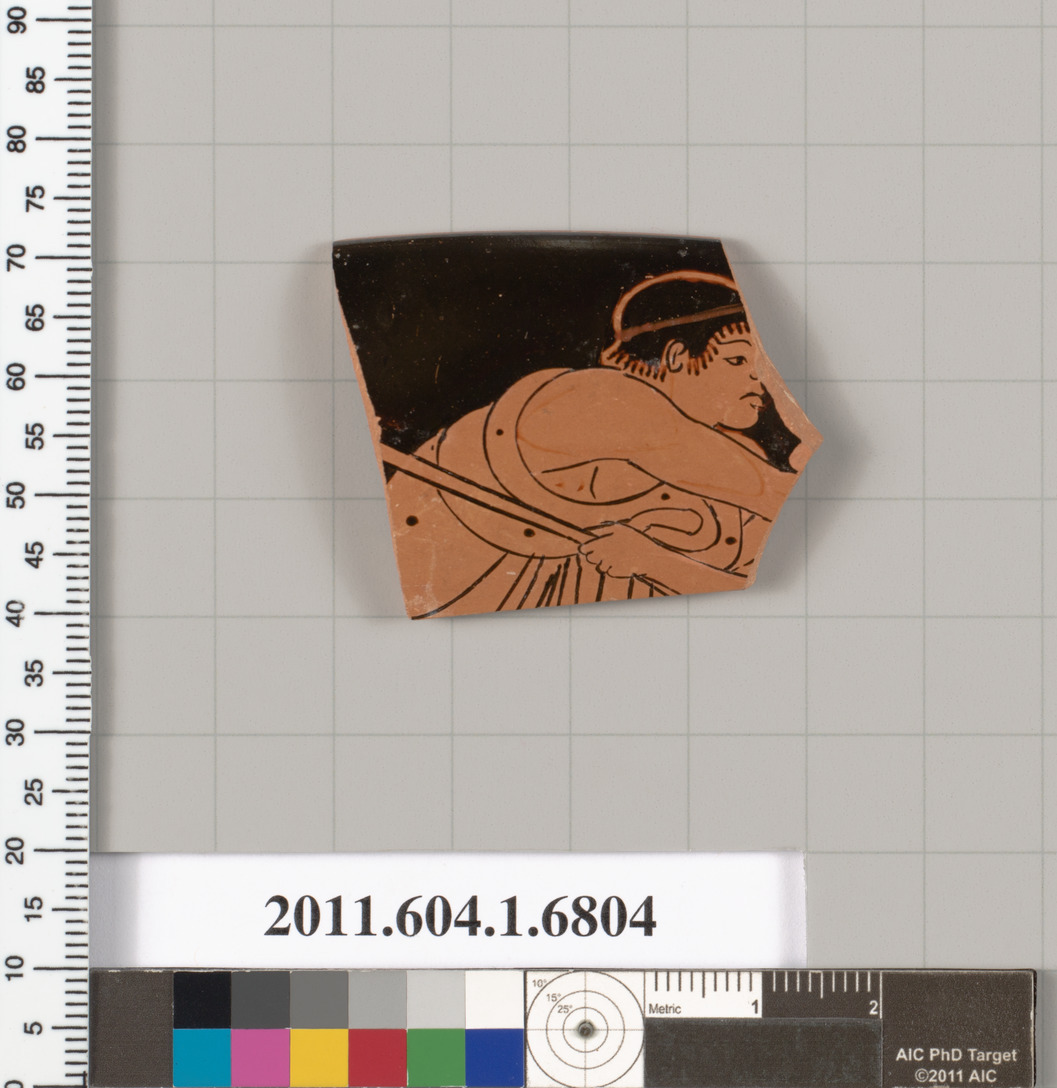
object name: kylix fragment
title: Terracotta rim fragment of a kylix (drinking cup)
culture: greek, attic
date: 490-470 BCE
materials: terracotta